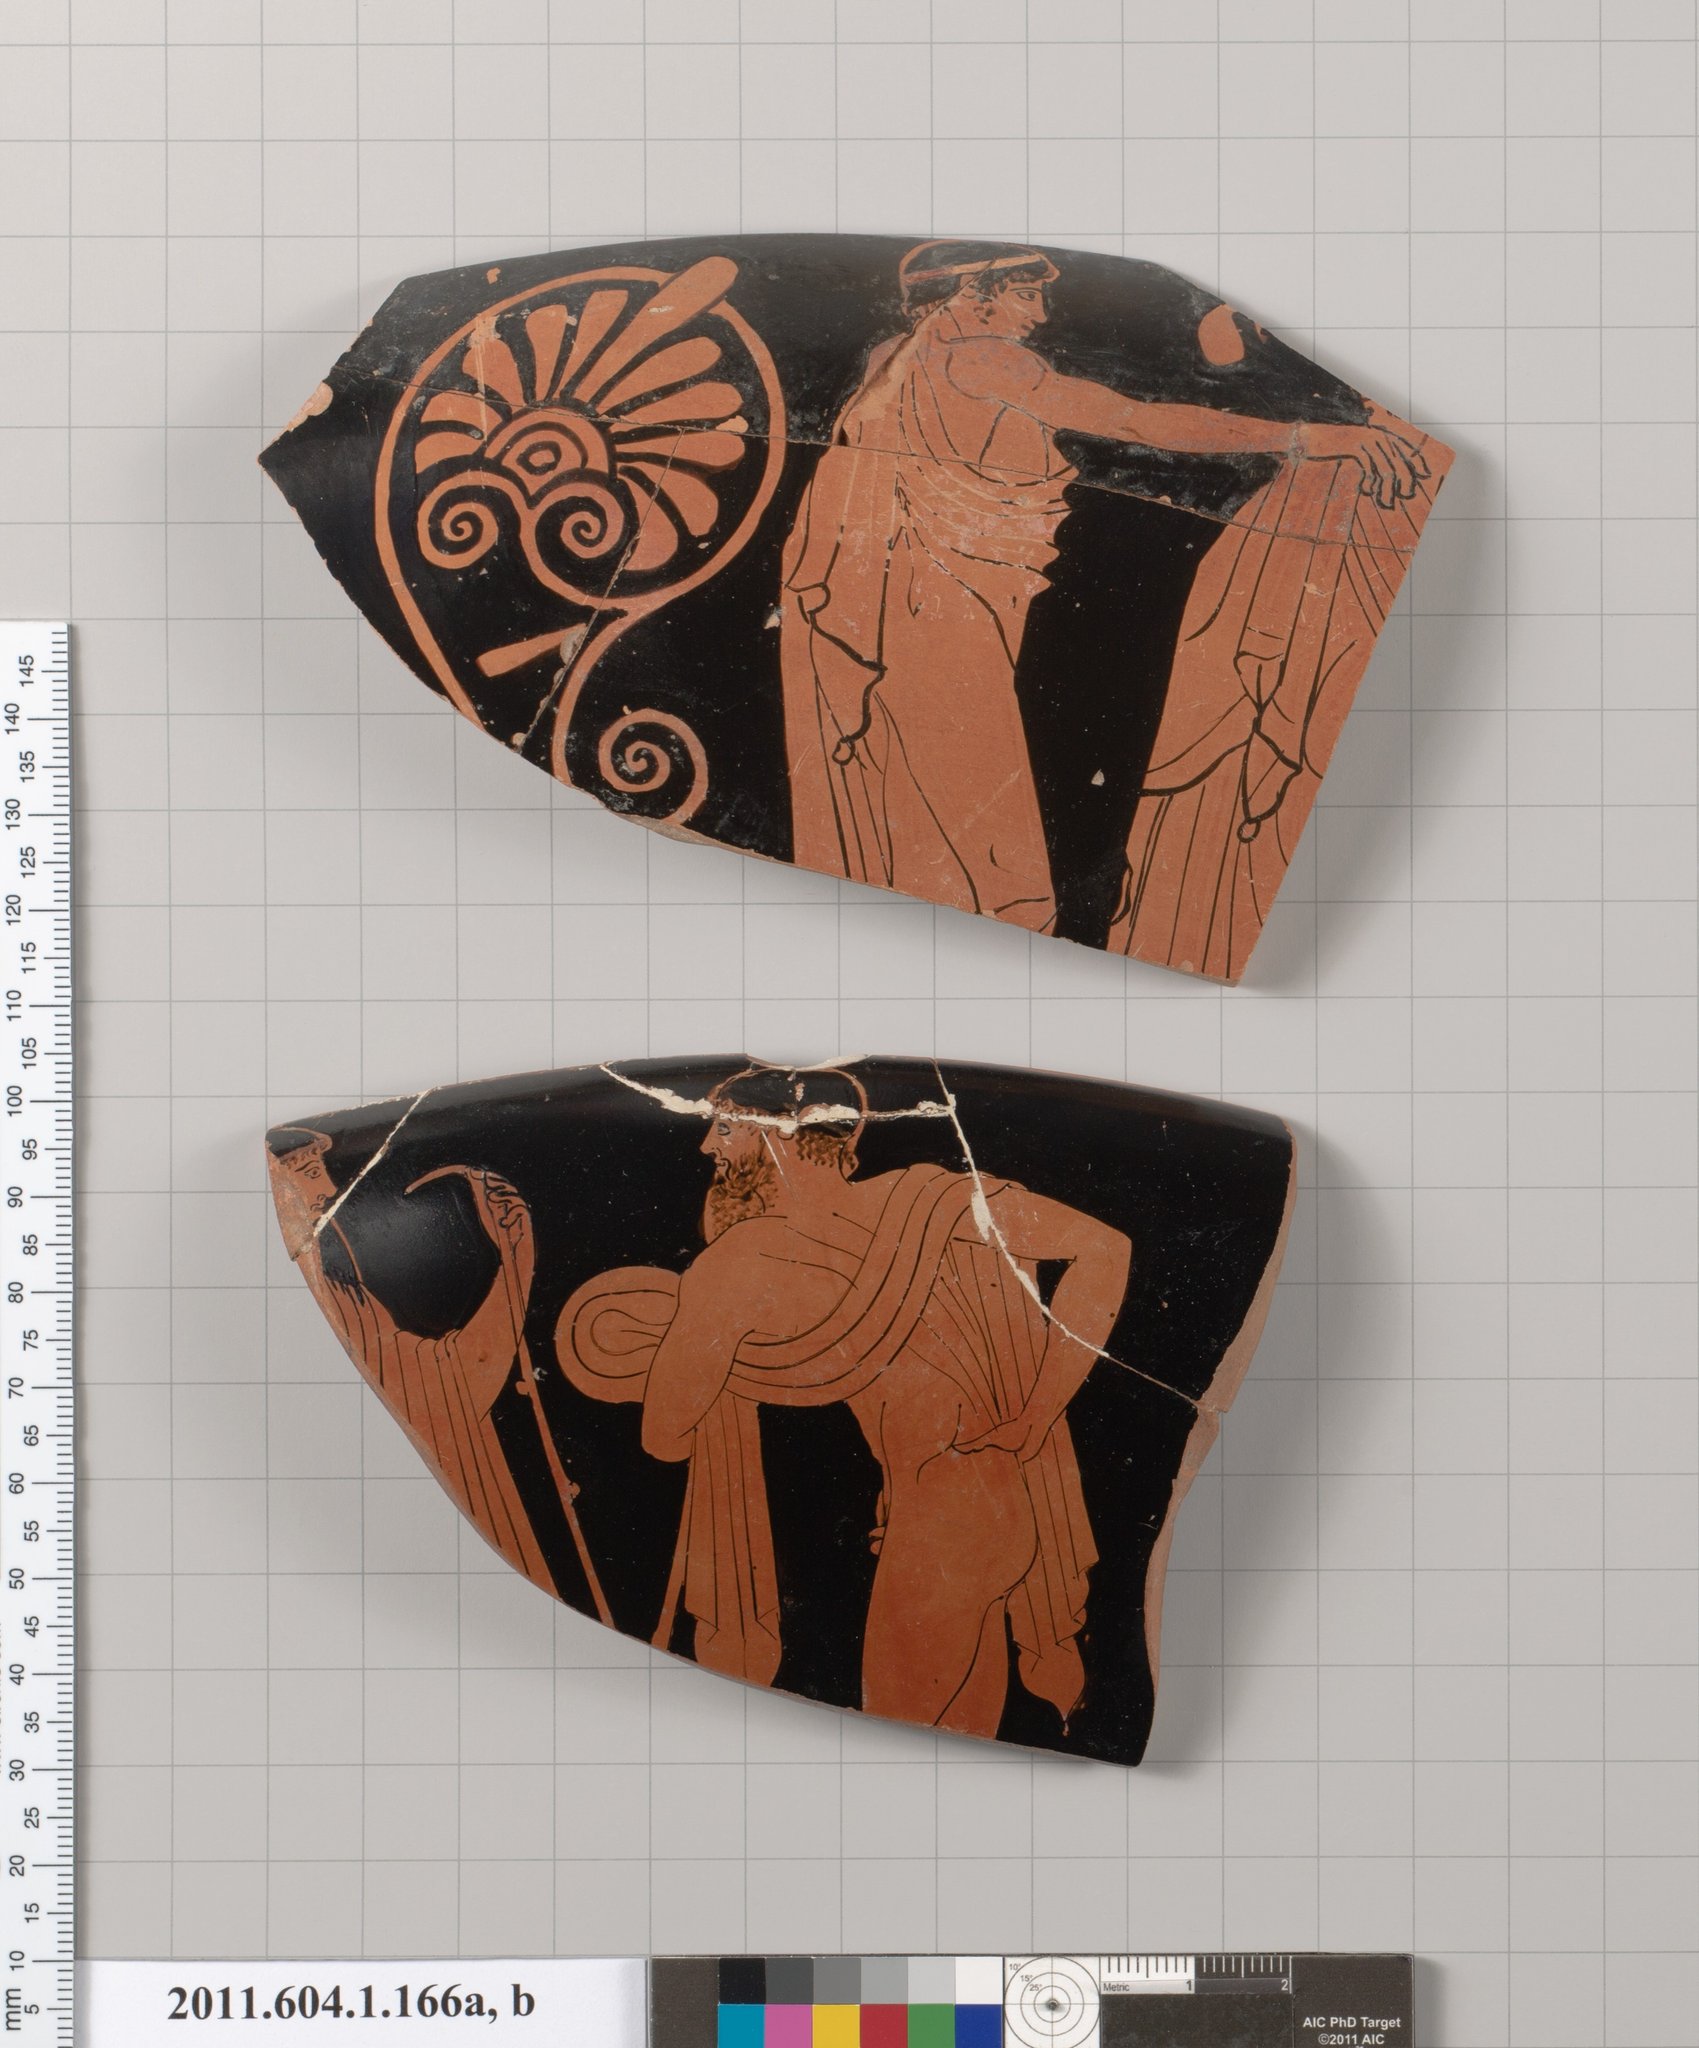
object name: kylix fragment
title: Terracotta rim fragments of a kylix (drinking cup)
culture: greek, attic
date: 470-450 BCE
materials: terracotta